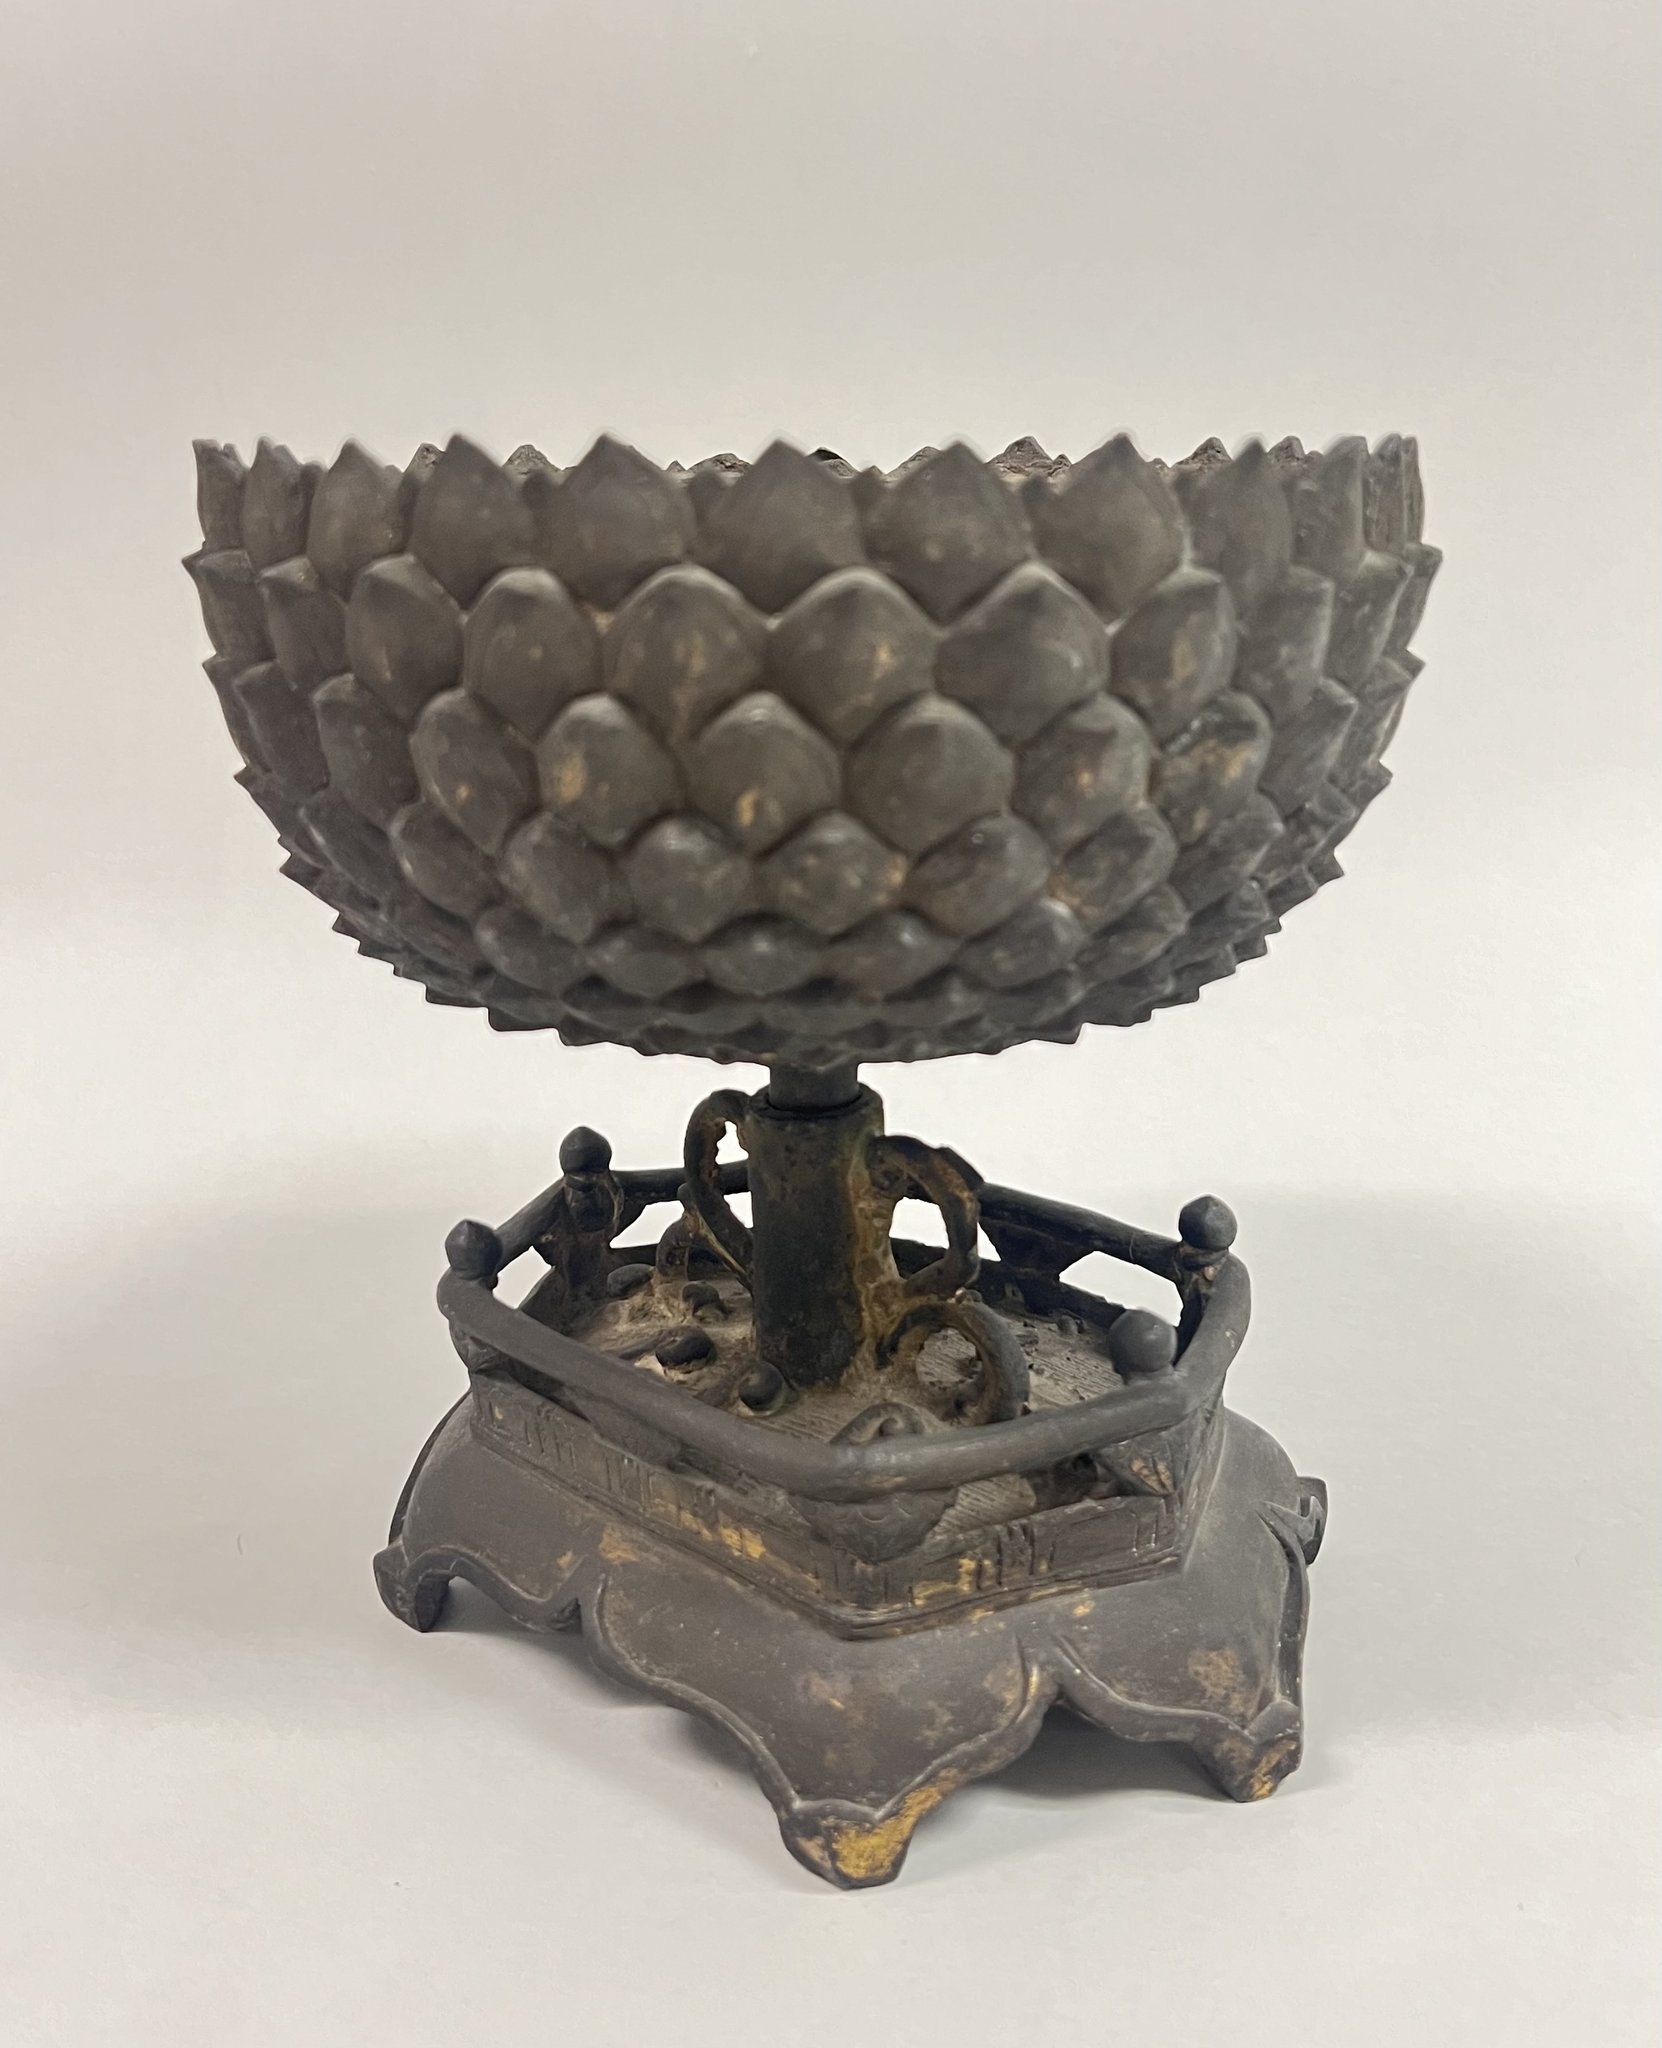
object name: incense burner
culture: japanese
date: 1601-1700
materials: brass